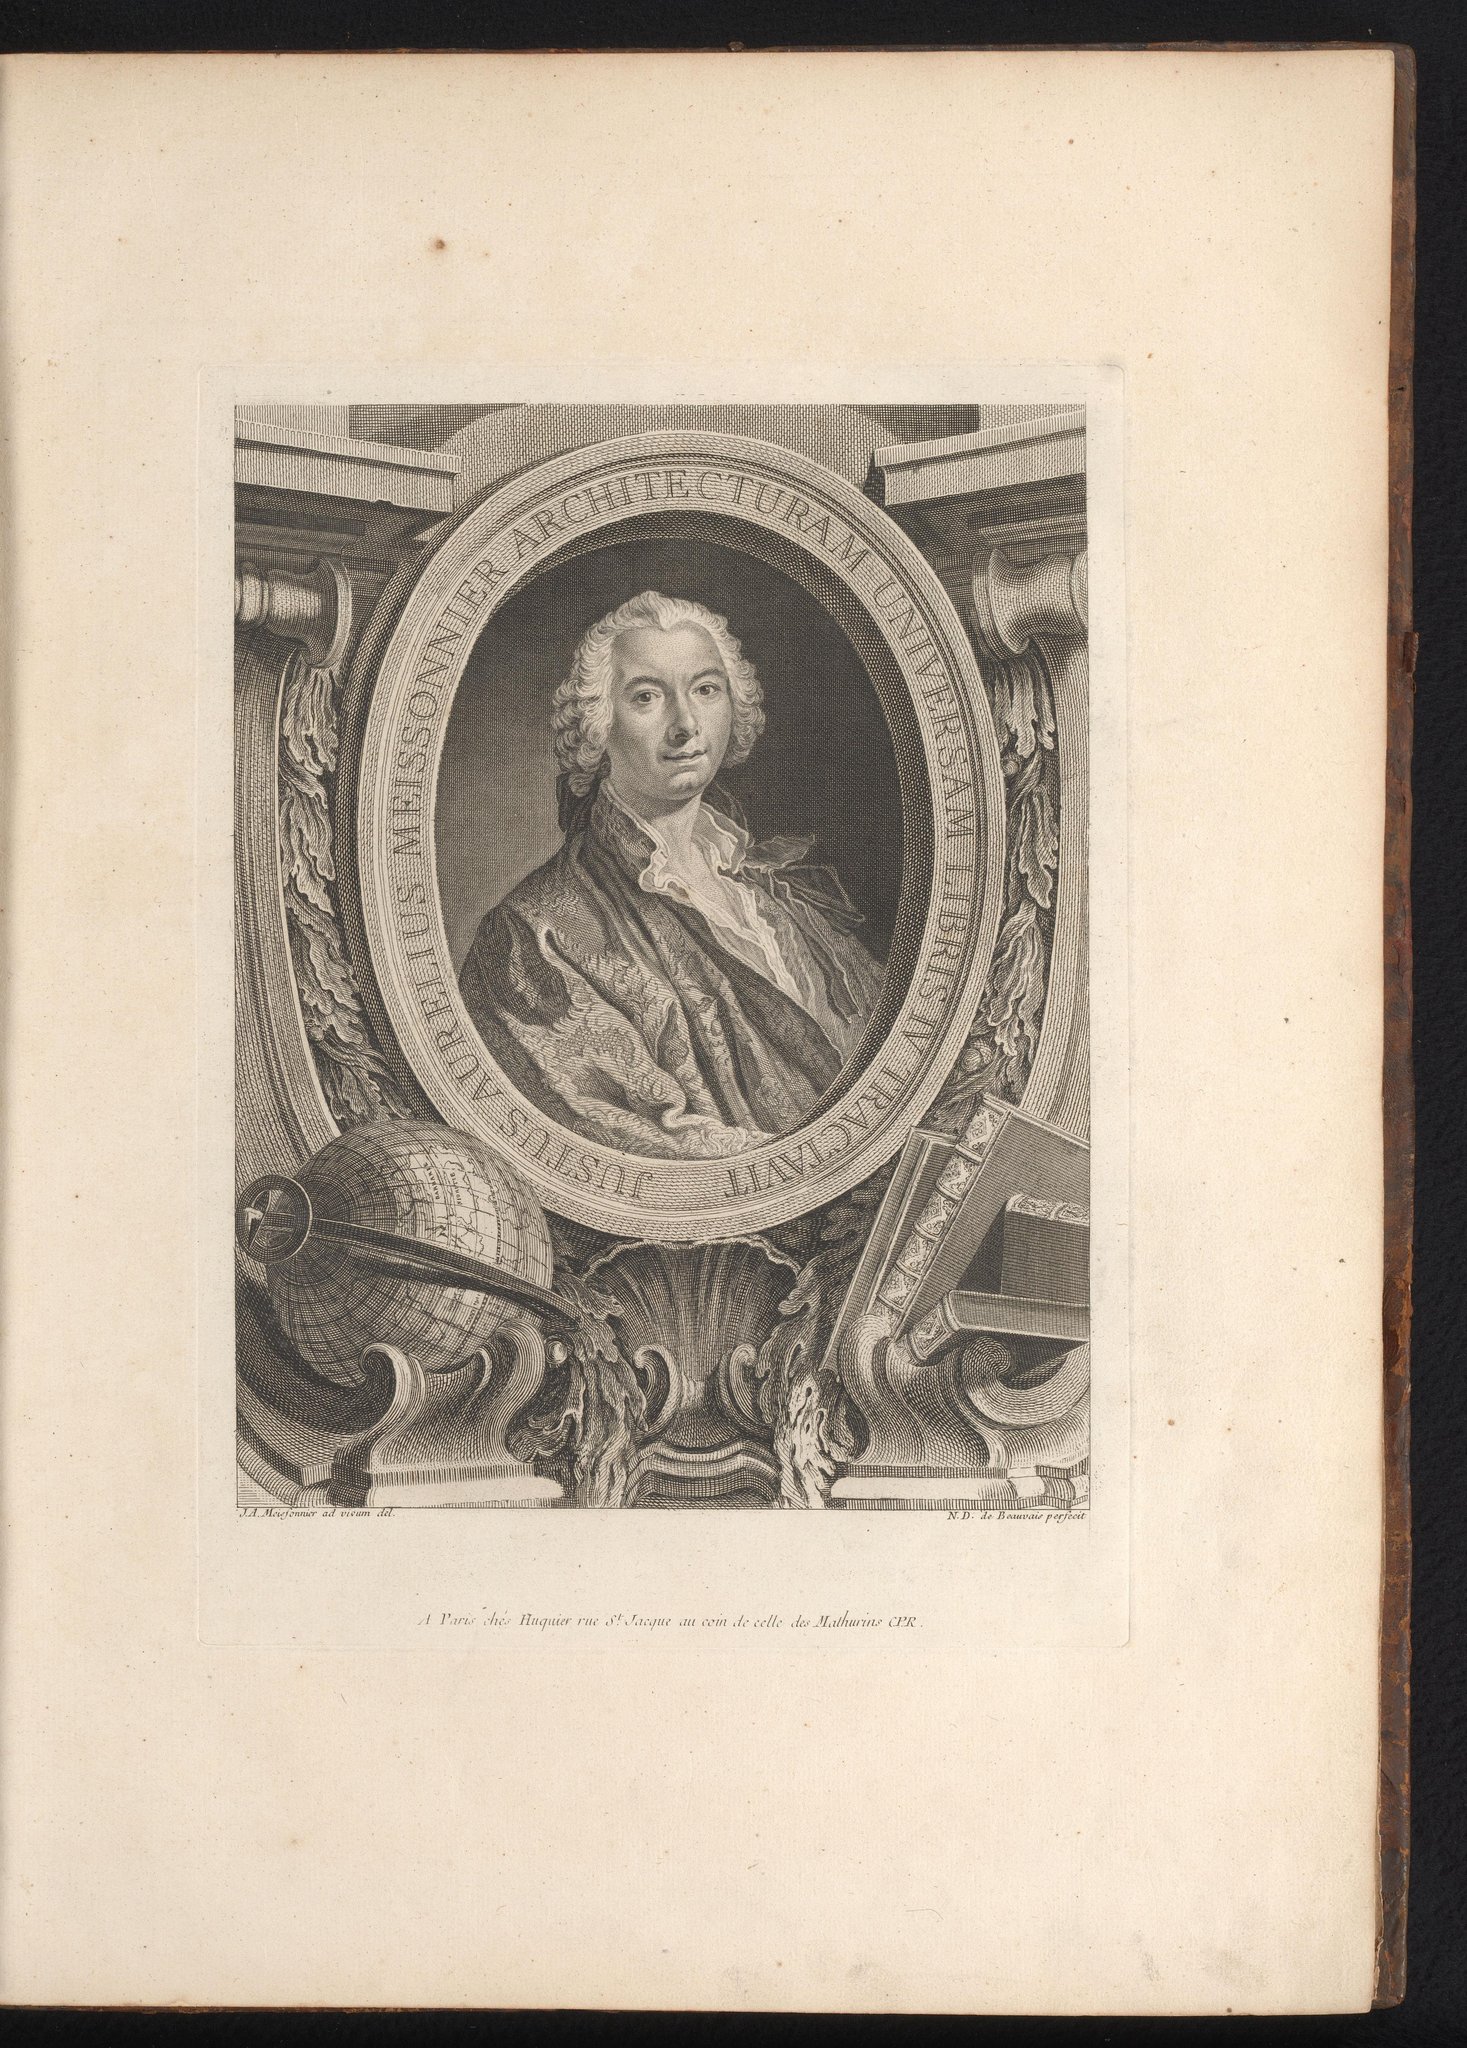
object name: album leaf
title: Portret van Juste-Aurèle Meissonnier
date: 1738-1749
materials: paper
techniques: etching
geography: paris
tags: paris, draughtsman, juste aurèle meissonnier, portrait, self-portrait of architect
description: Deze prent maakt deel uit van een album.